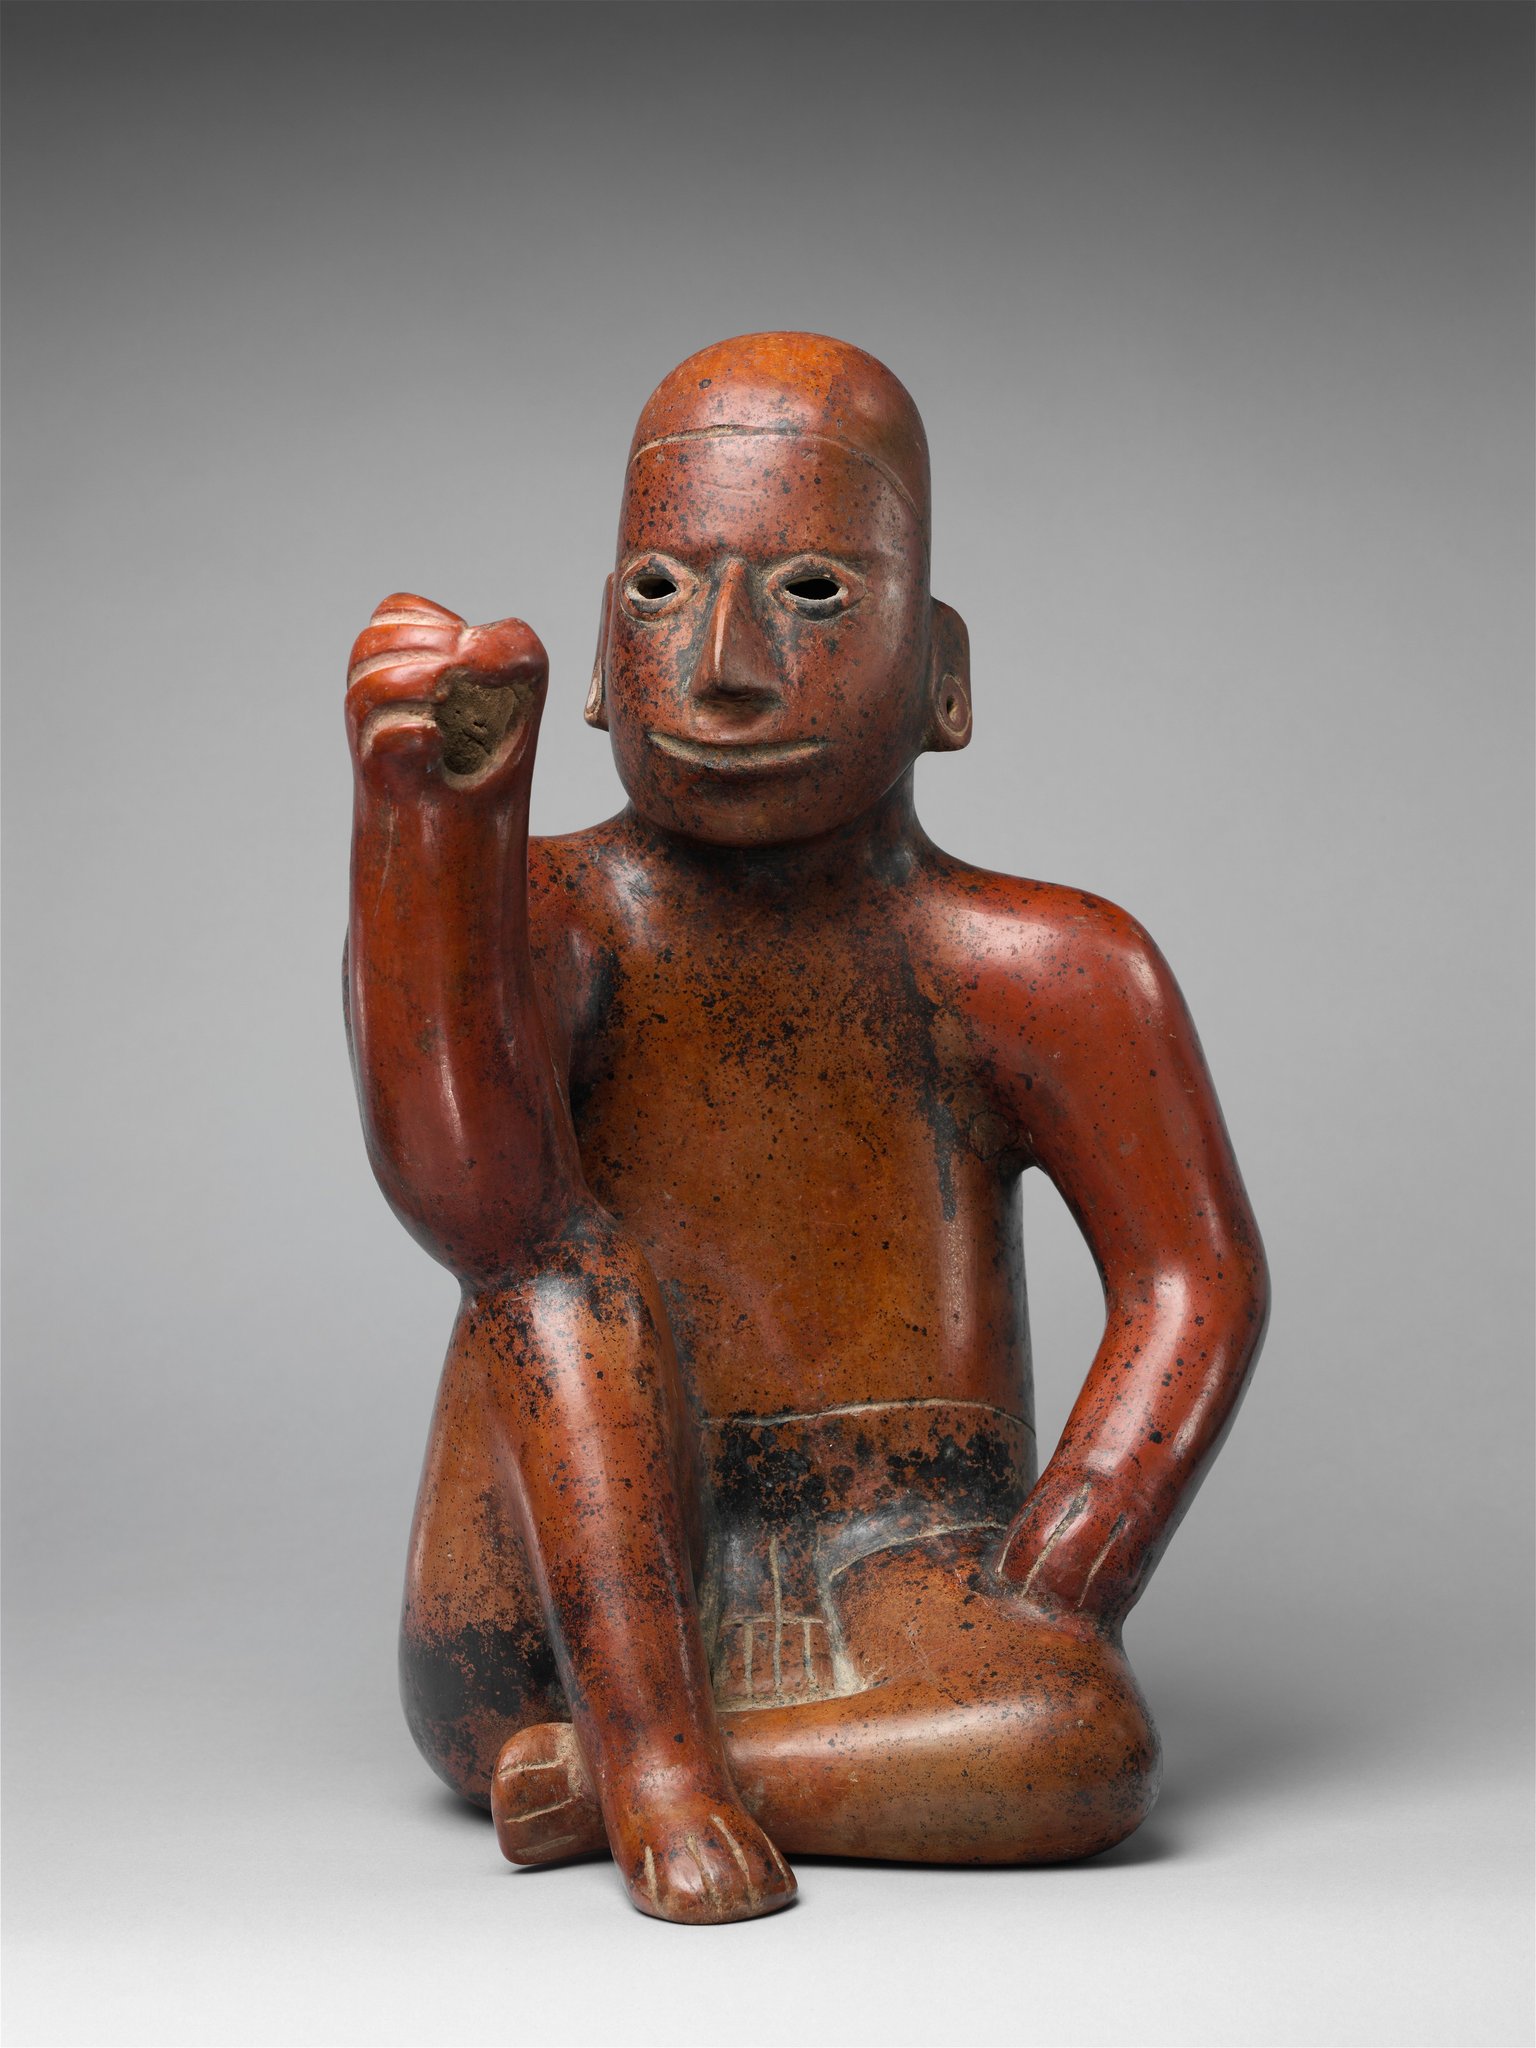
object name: male figure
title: Standard bearer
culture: colima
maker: colima artist(s)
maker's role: artist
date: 200 BCE-300 CE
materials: ceramic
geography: west mexico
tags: men